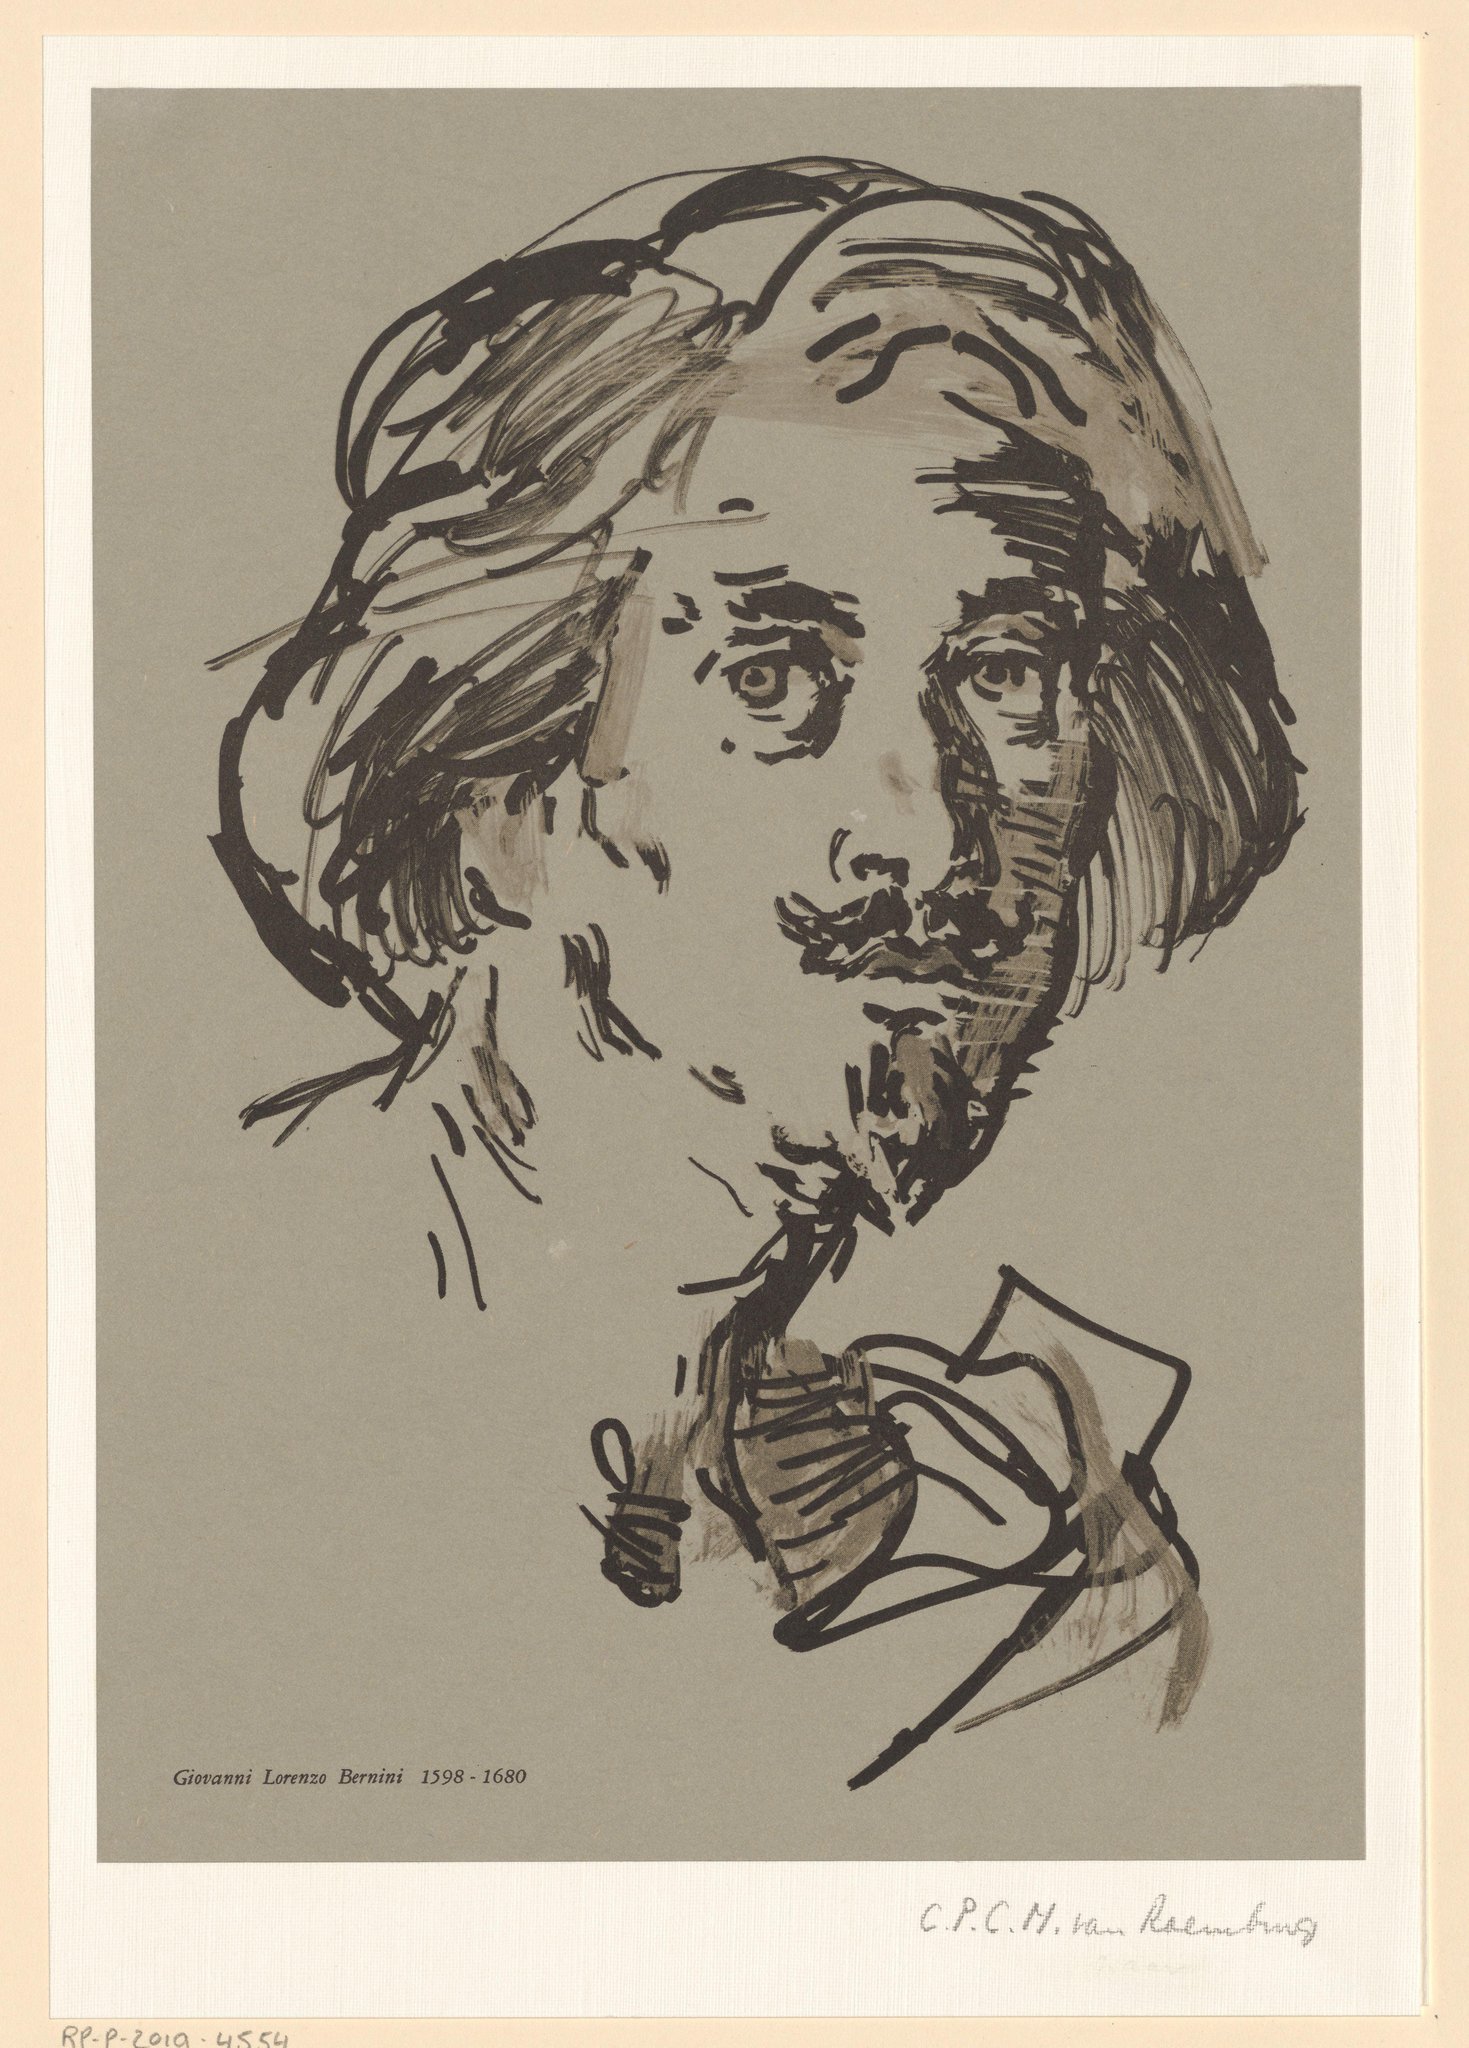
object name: photomechanical print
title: Portret van Giovanni Lorenzo Bernini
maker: Anonymous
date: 1960-1990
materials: paper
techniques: rotogravure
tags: naples, rome, painter, draughtsman, gian lorenzo bernini, portrait, self-portrait of sculptor, historical persons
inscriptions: inscription: ‘C.P.C.M. van Roemburg’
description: Met op het opzetvet een korte biografie van Bernini door R.S. Stokvis en Zonen.